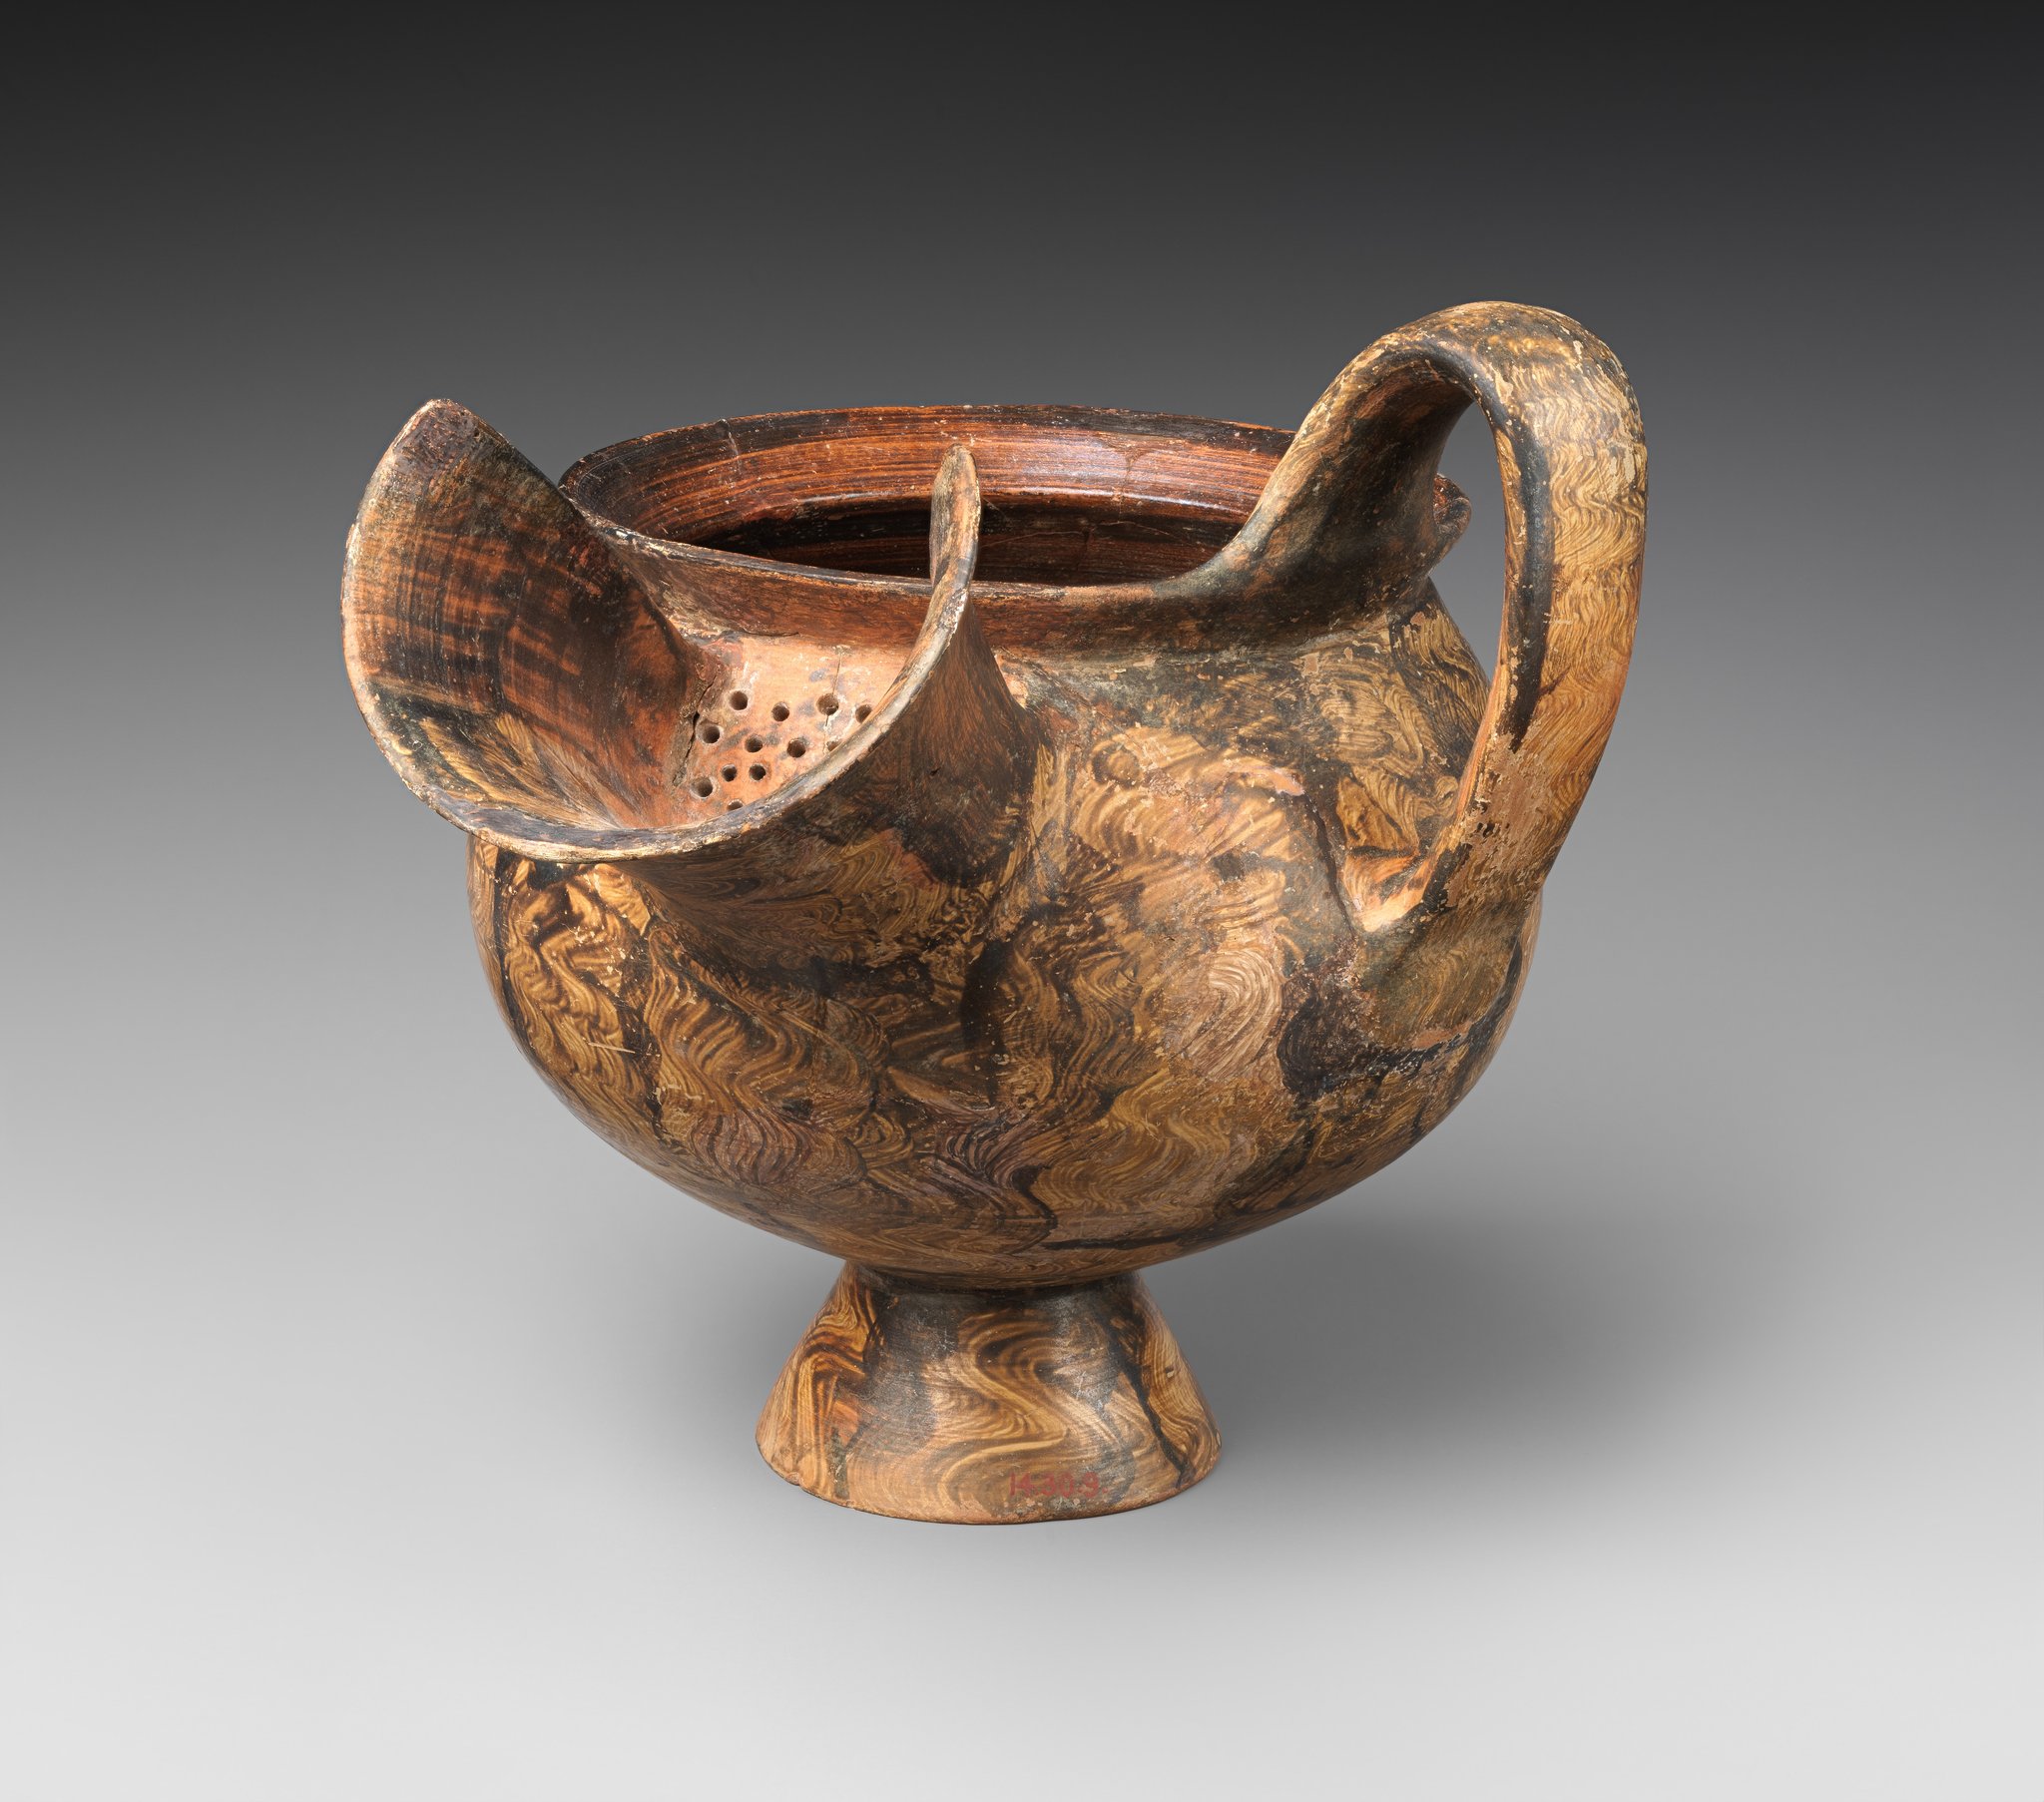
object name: vase with spout and strainer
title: Terracotta jug with an oversize spout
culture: lydian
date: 567-535 BCE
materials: terracotta